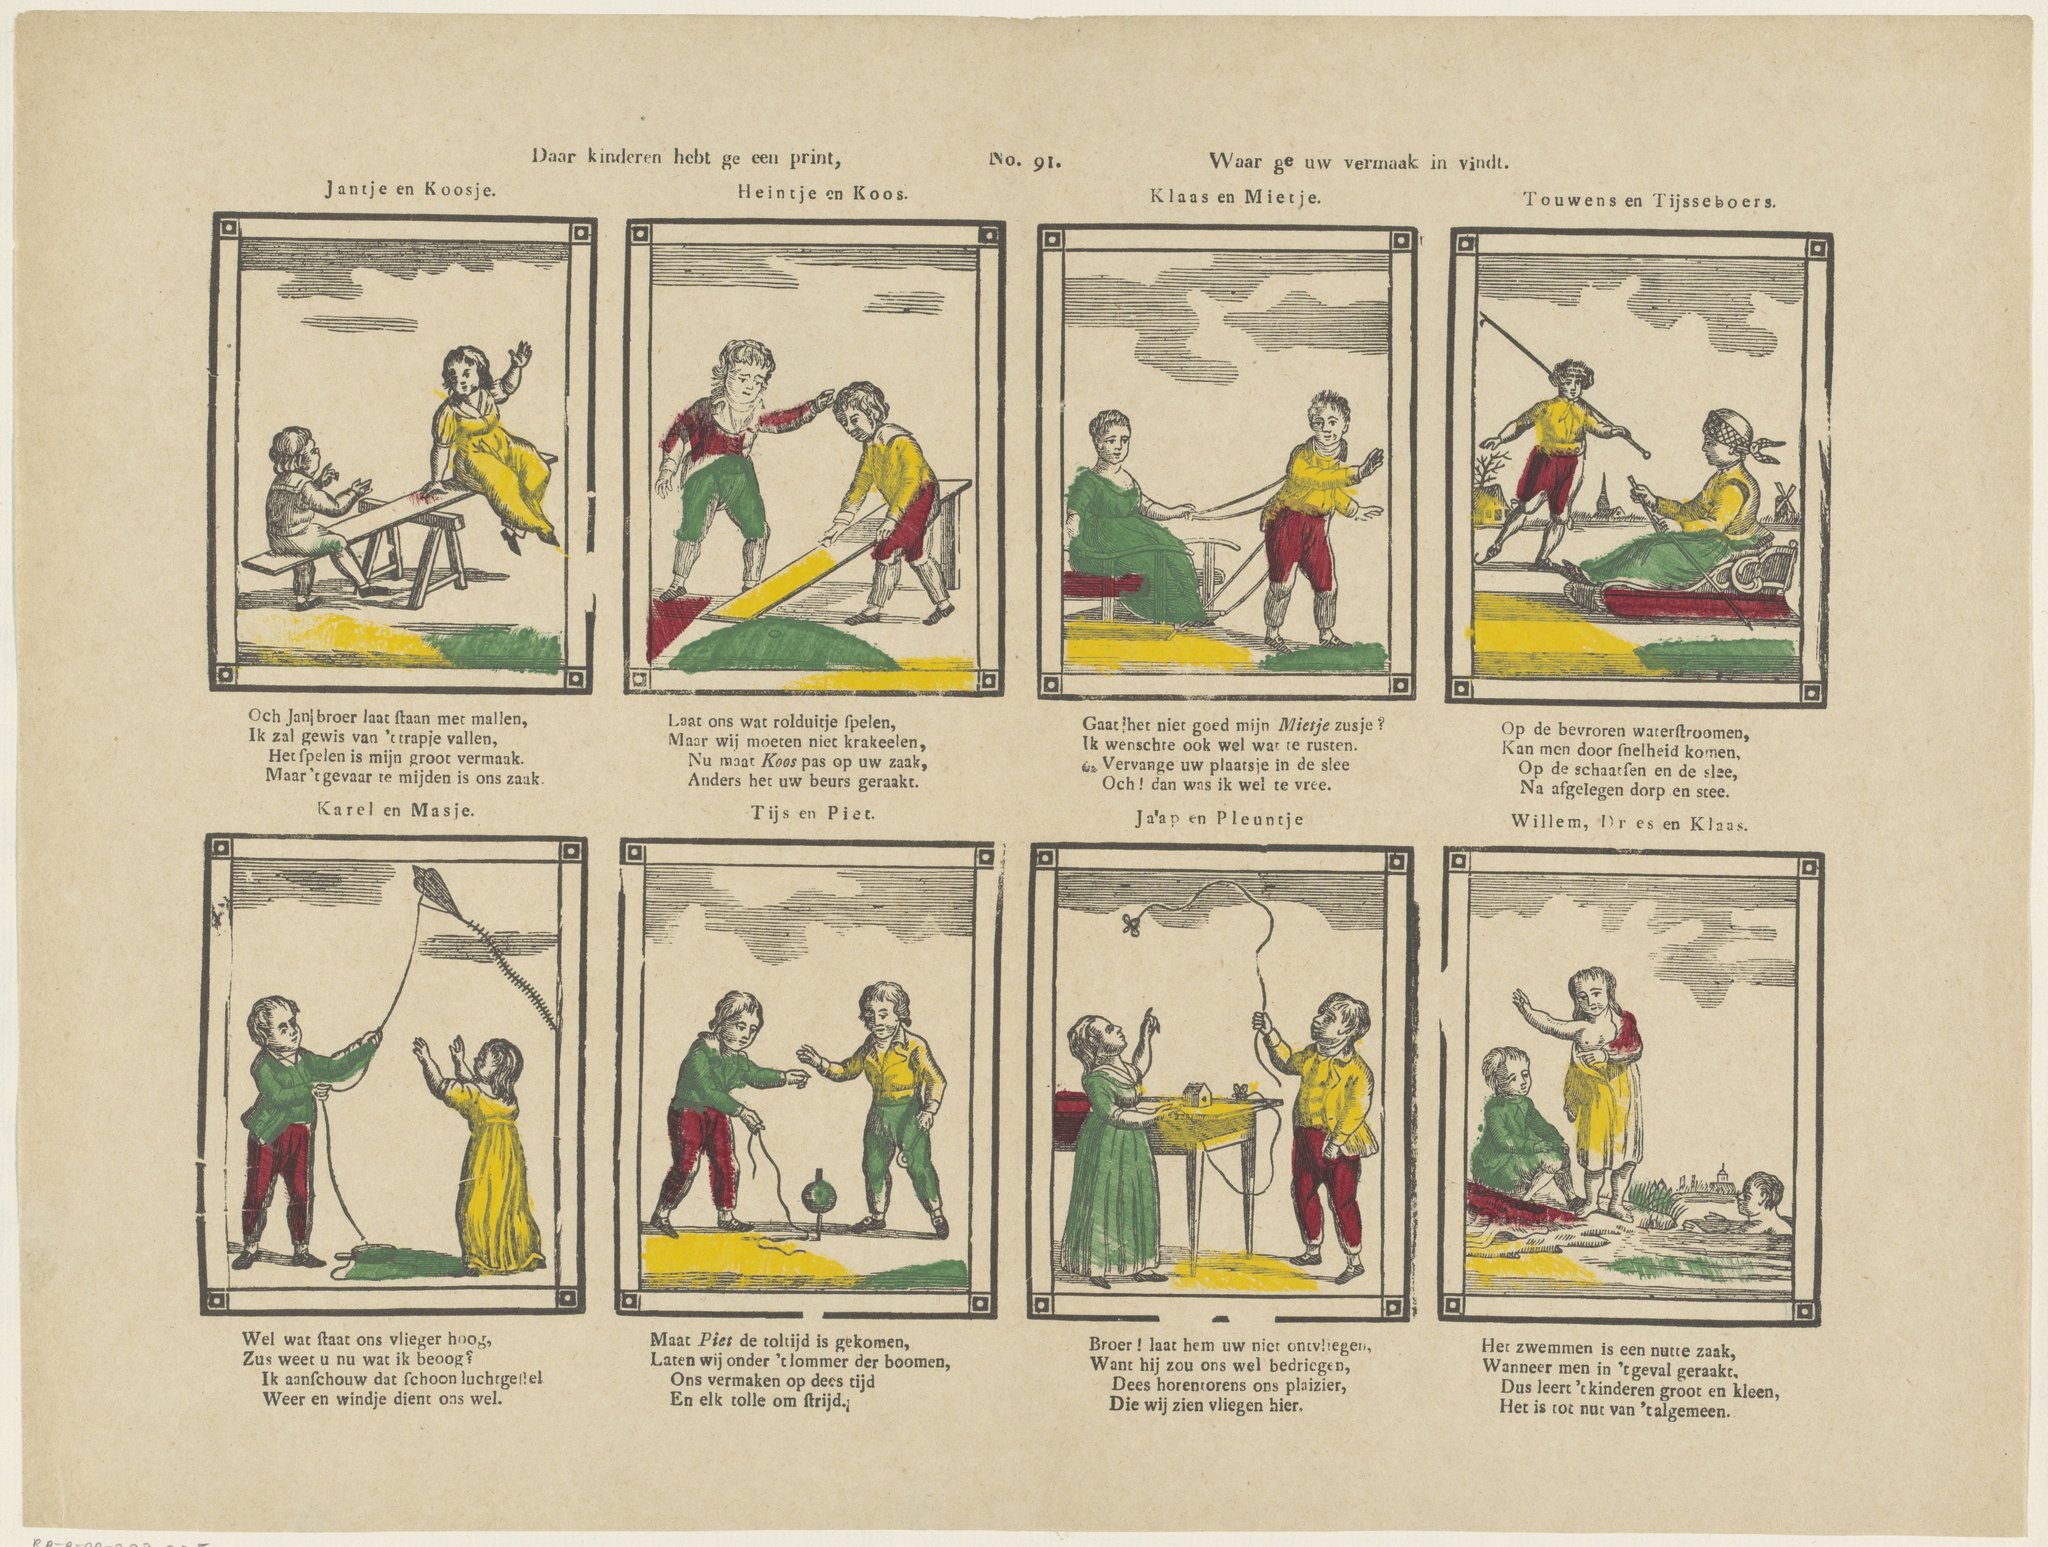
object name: popular print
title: Daar kinderen hebt ge een print, / Waar ge uw vermaak in vindt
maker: Anonymous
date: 1856-1900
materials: paper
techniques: colour, letterpress printing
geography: netherlands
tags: children's games and plays, (flying a) kite, games using special objects (marbles, top, hoop, etc.), seesaw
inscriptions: collector's mark: Lugt 2760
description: Blad met 8 voorstellingen van kinderspelen, zoals wippen, vliegeren en tollen. Boven elke afbeelding de namen van de kinderen, onder elke afbeelding een vierregelig vers. Genummerd midden boven: No. 91.